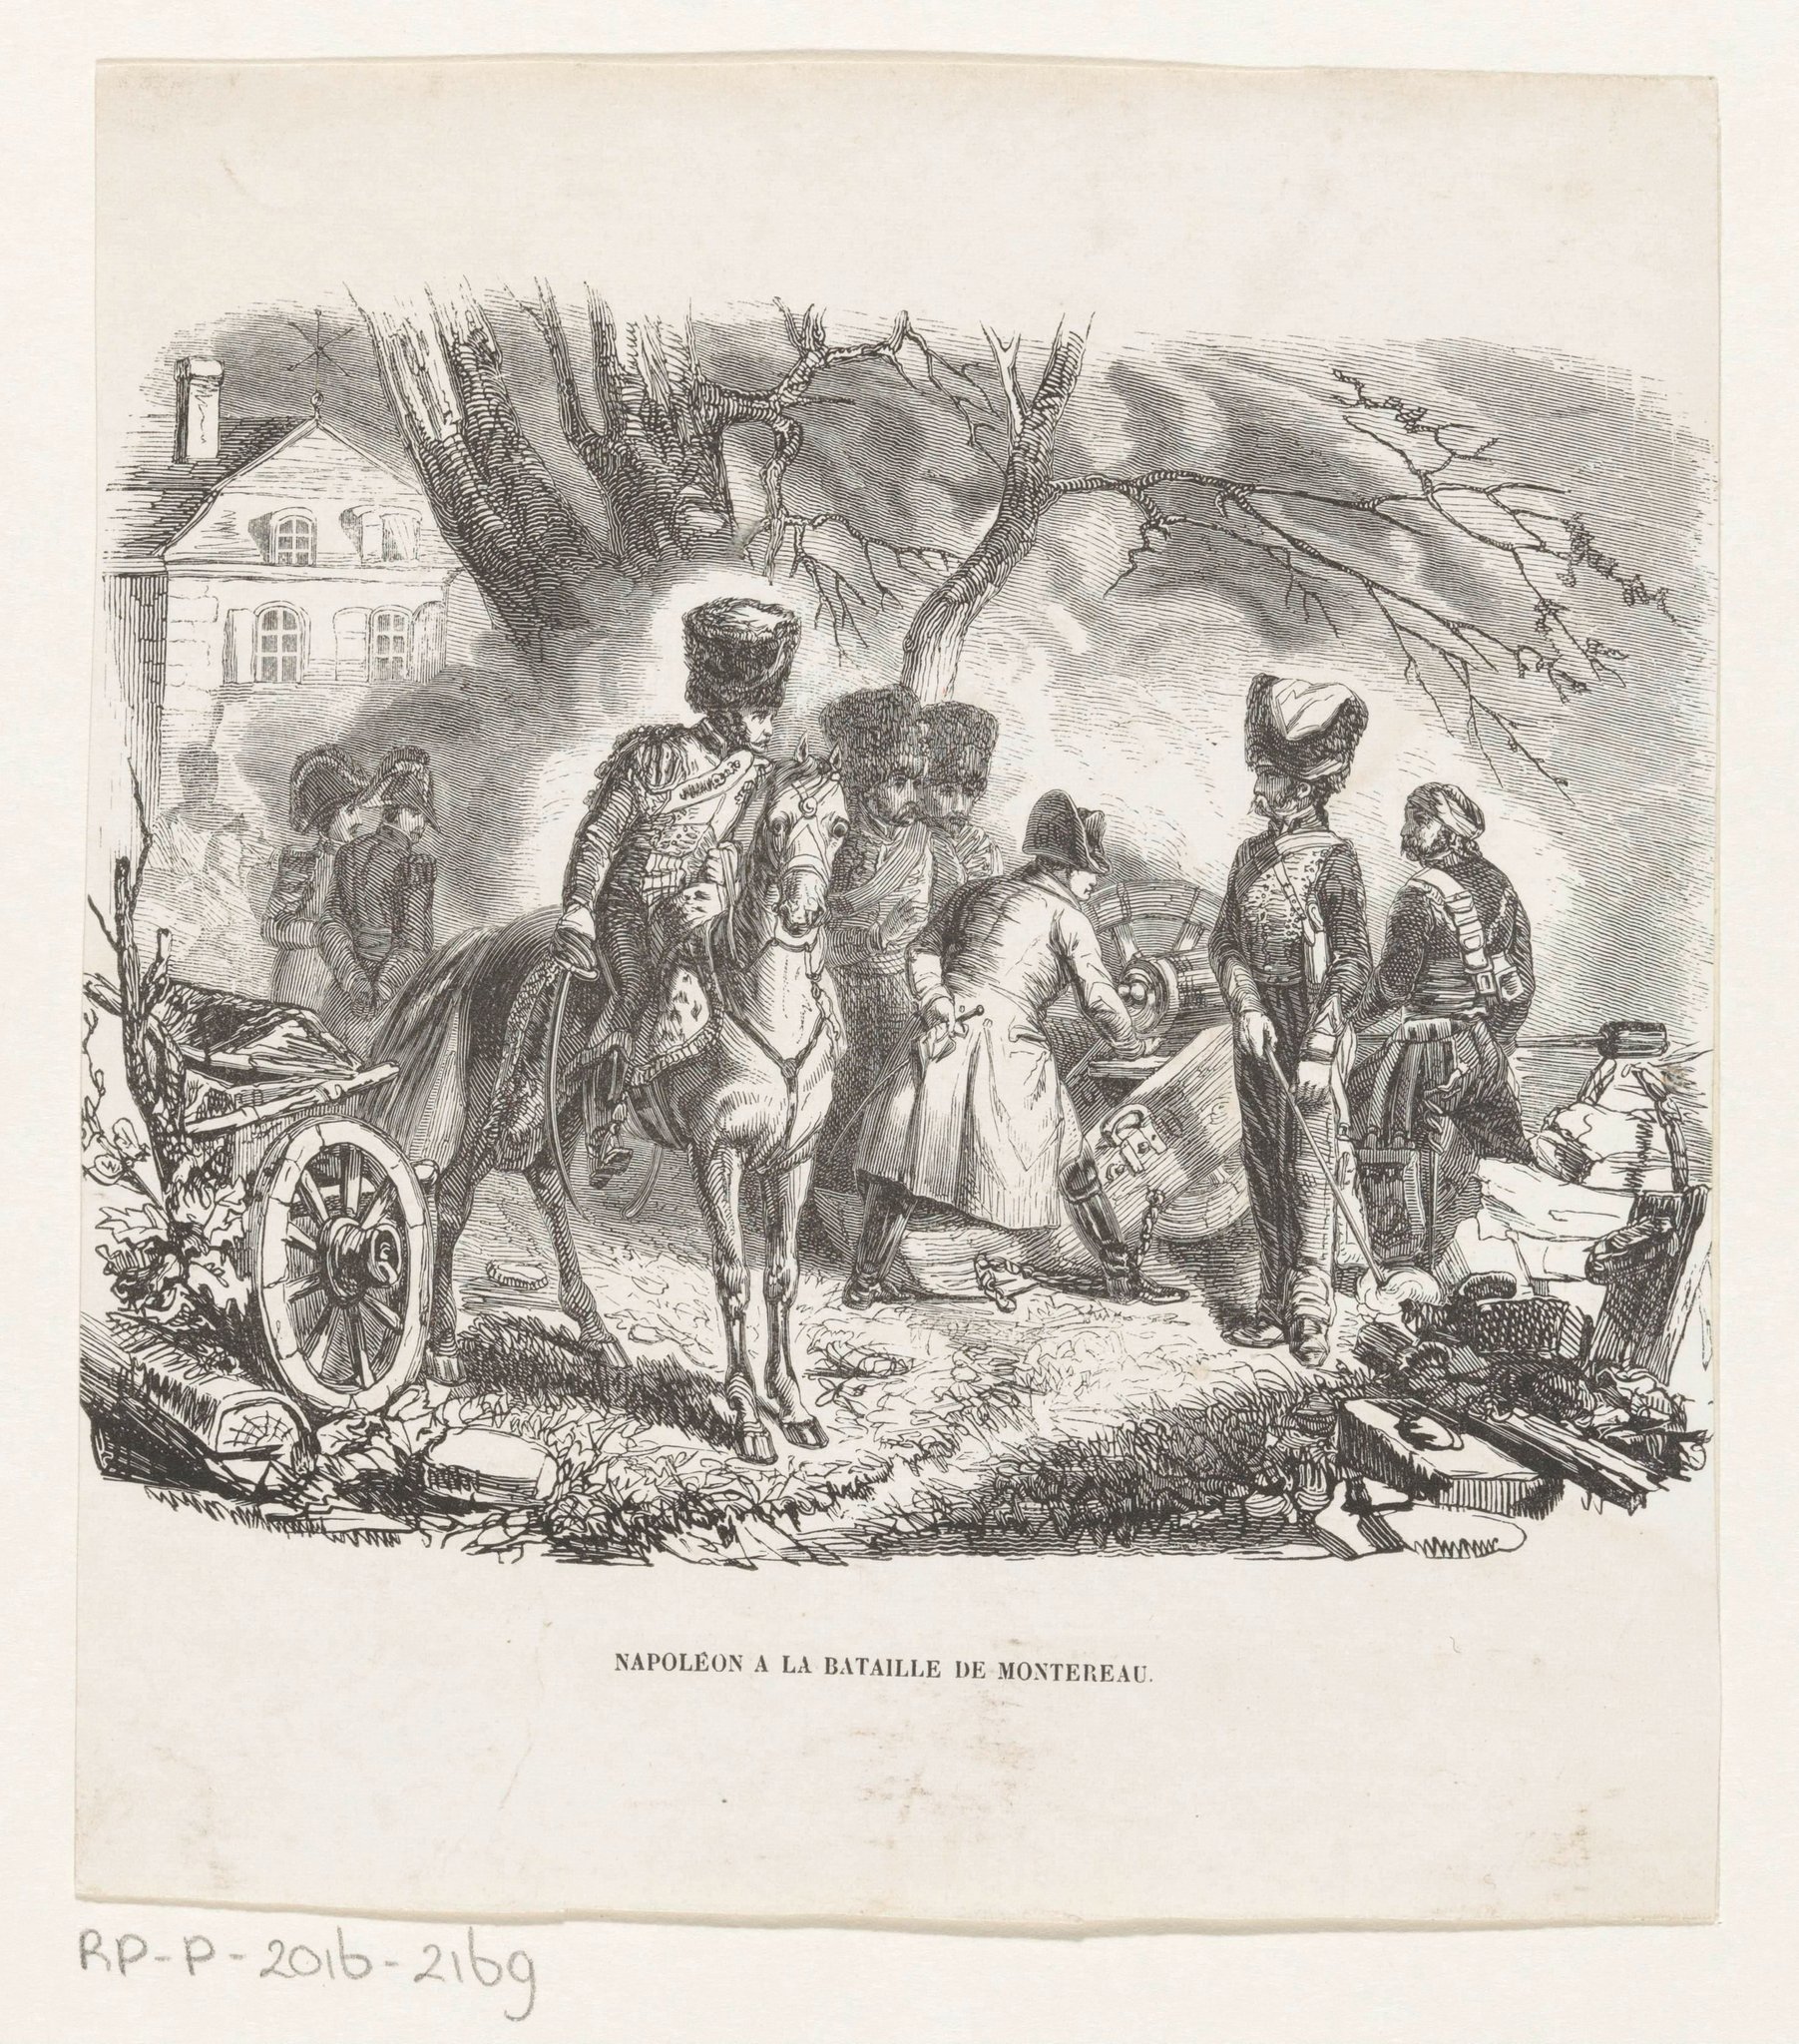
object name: print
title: Napoleon bij de slag van Montereau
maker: Anonymous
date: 1814-1844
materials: paper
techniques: lithograph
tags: napoleon i (emperor of the french), battle, firearms: cannon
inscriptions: collector's mark: Lugt 2228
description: Afbeelding komt ook voor op een bordenserie van BOCH. In de periode 1844-1870 produceerde BOCH Freres een serie van faience-waar, meestal uitgegeven in reeksen van twaalf, met onder andere veldslagen van Napoleon. De serie werd in de jaren 1920-1950 opnieuw geproduceert. Prent afkomstig uit een plakalbum met titelprenten, ornamenten etc. op blauw papier in 1983 uit elkaar gehaald.